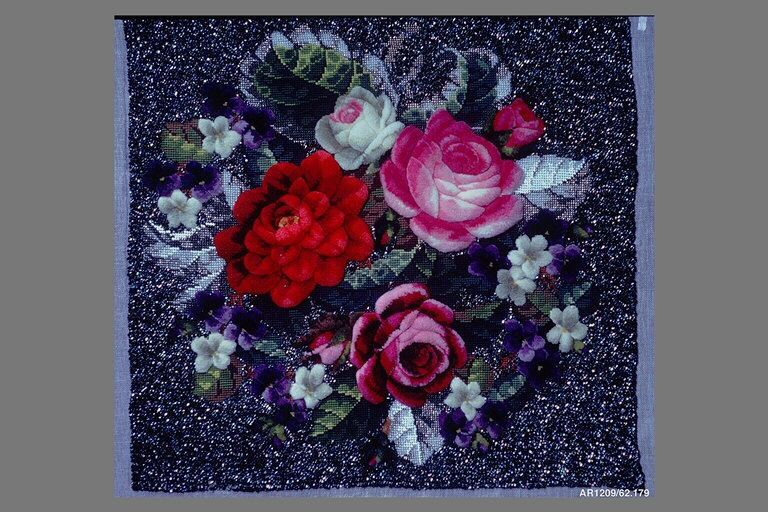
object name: cushion cover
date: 1834-1866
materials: canvas, glass, linen, wool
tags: roses